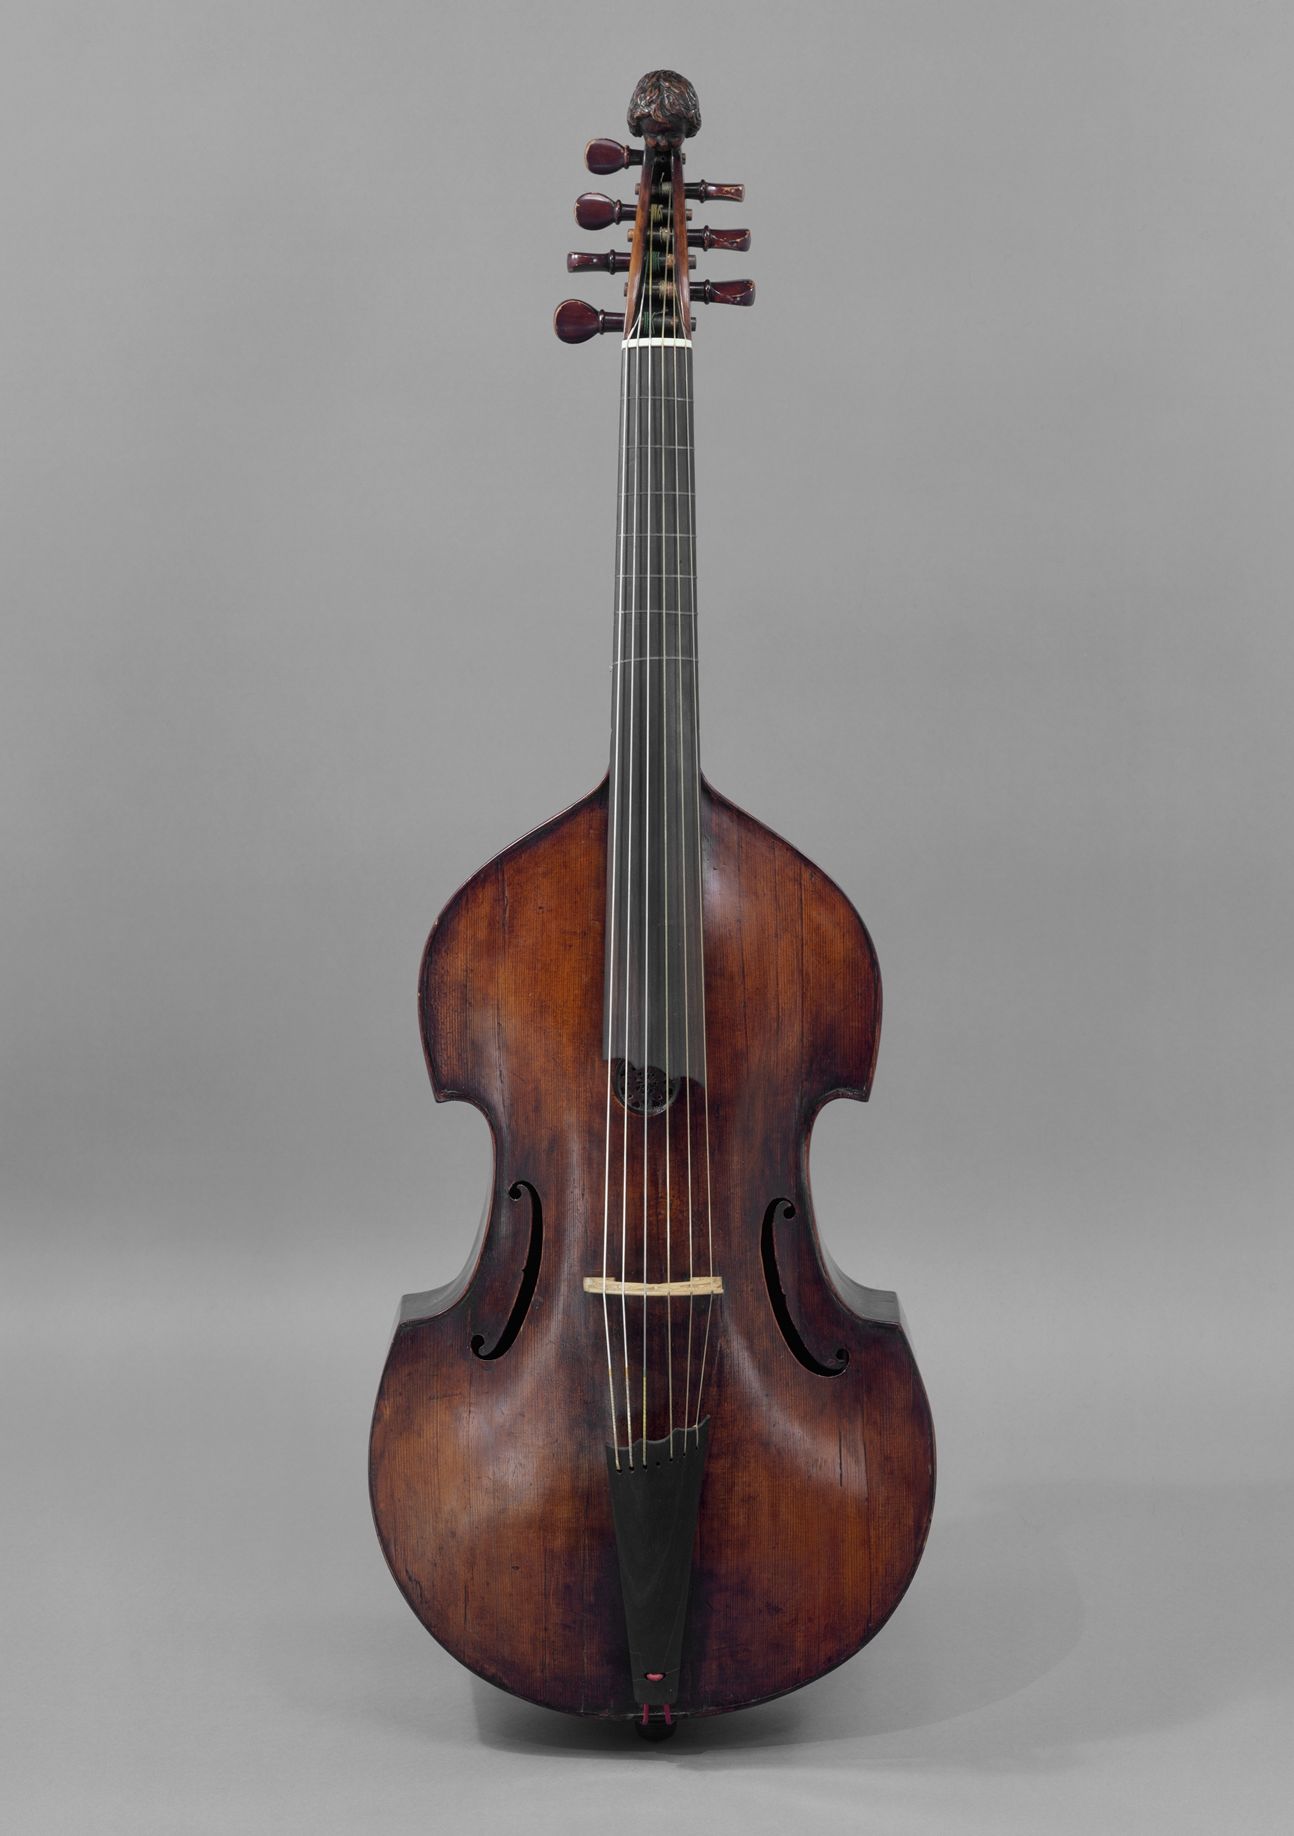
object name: bass viol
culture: german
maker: matthias humel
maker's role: maker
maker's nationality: german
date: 1701-1800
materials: wood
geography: germany